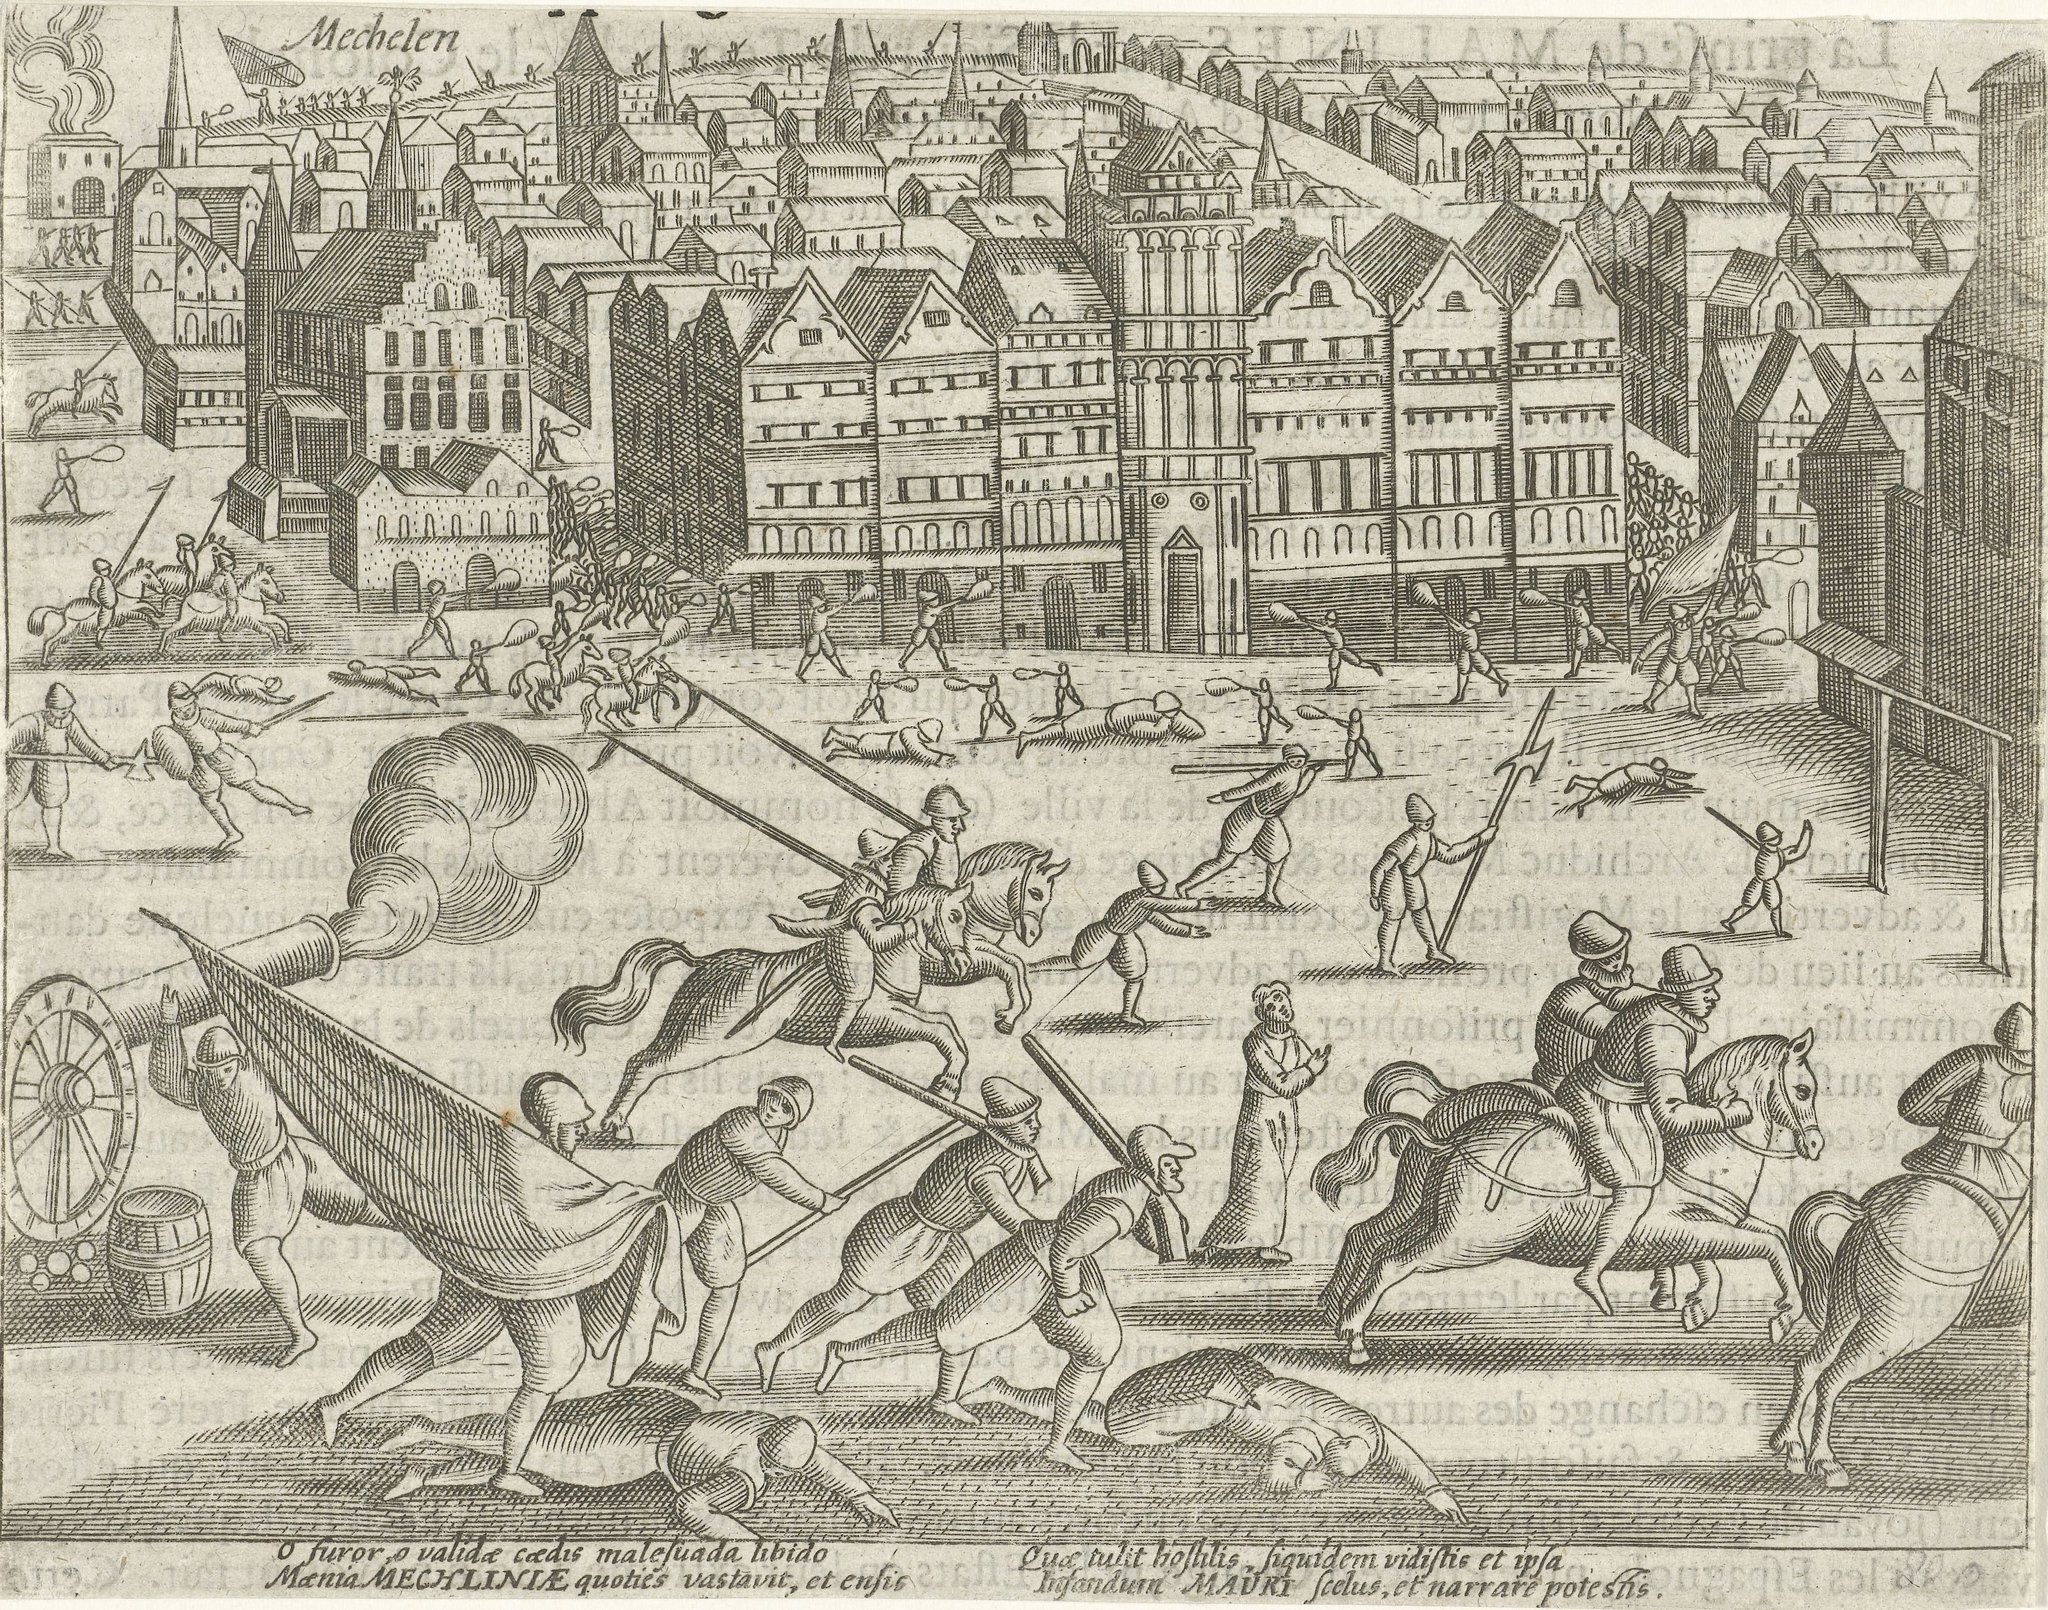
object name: history print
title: Verovering van Mechelen, 1580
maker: Anonymous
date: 1613-1615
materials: paper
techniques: engraving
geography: northern netherlands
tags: capture of city (after the siege), massacre ~ war, mechelen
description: Verovering van Mechelen door het Staatse leger van Engelse soldaten, 9 april 1580. Vluchtende burgers, plundering en moord in de stad door het leger van Engelsen onder bevel van Olivier van den Tempel en John Norrits. Met onderschrift van 4 regels in het Latijn. Het nummer weggekrabd. Bedrukt op achterzijde met tekst in het Latijn.